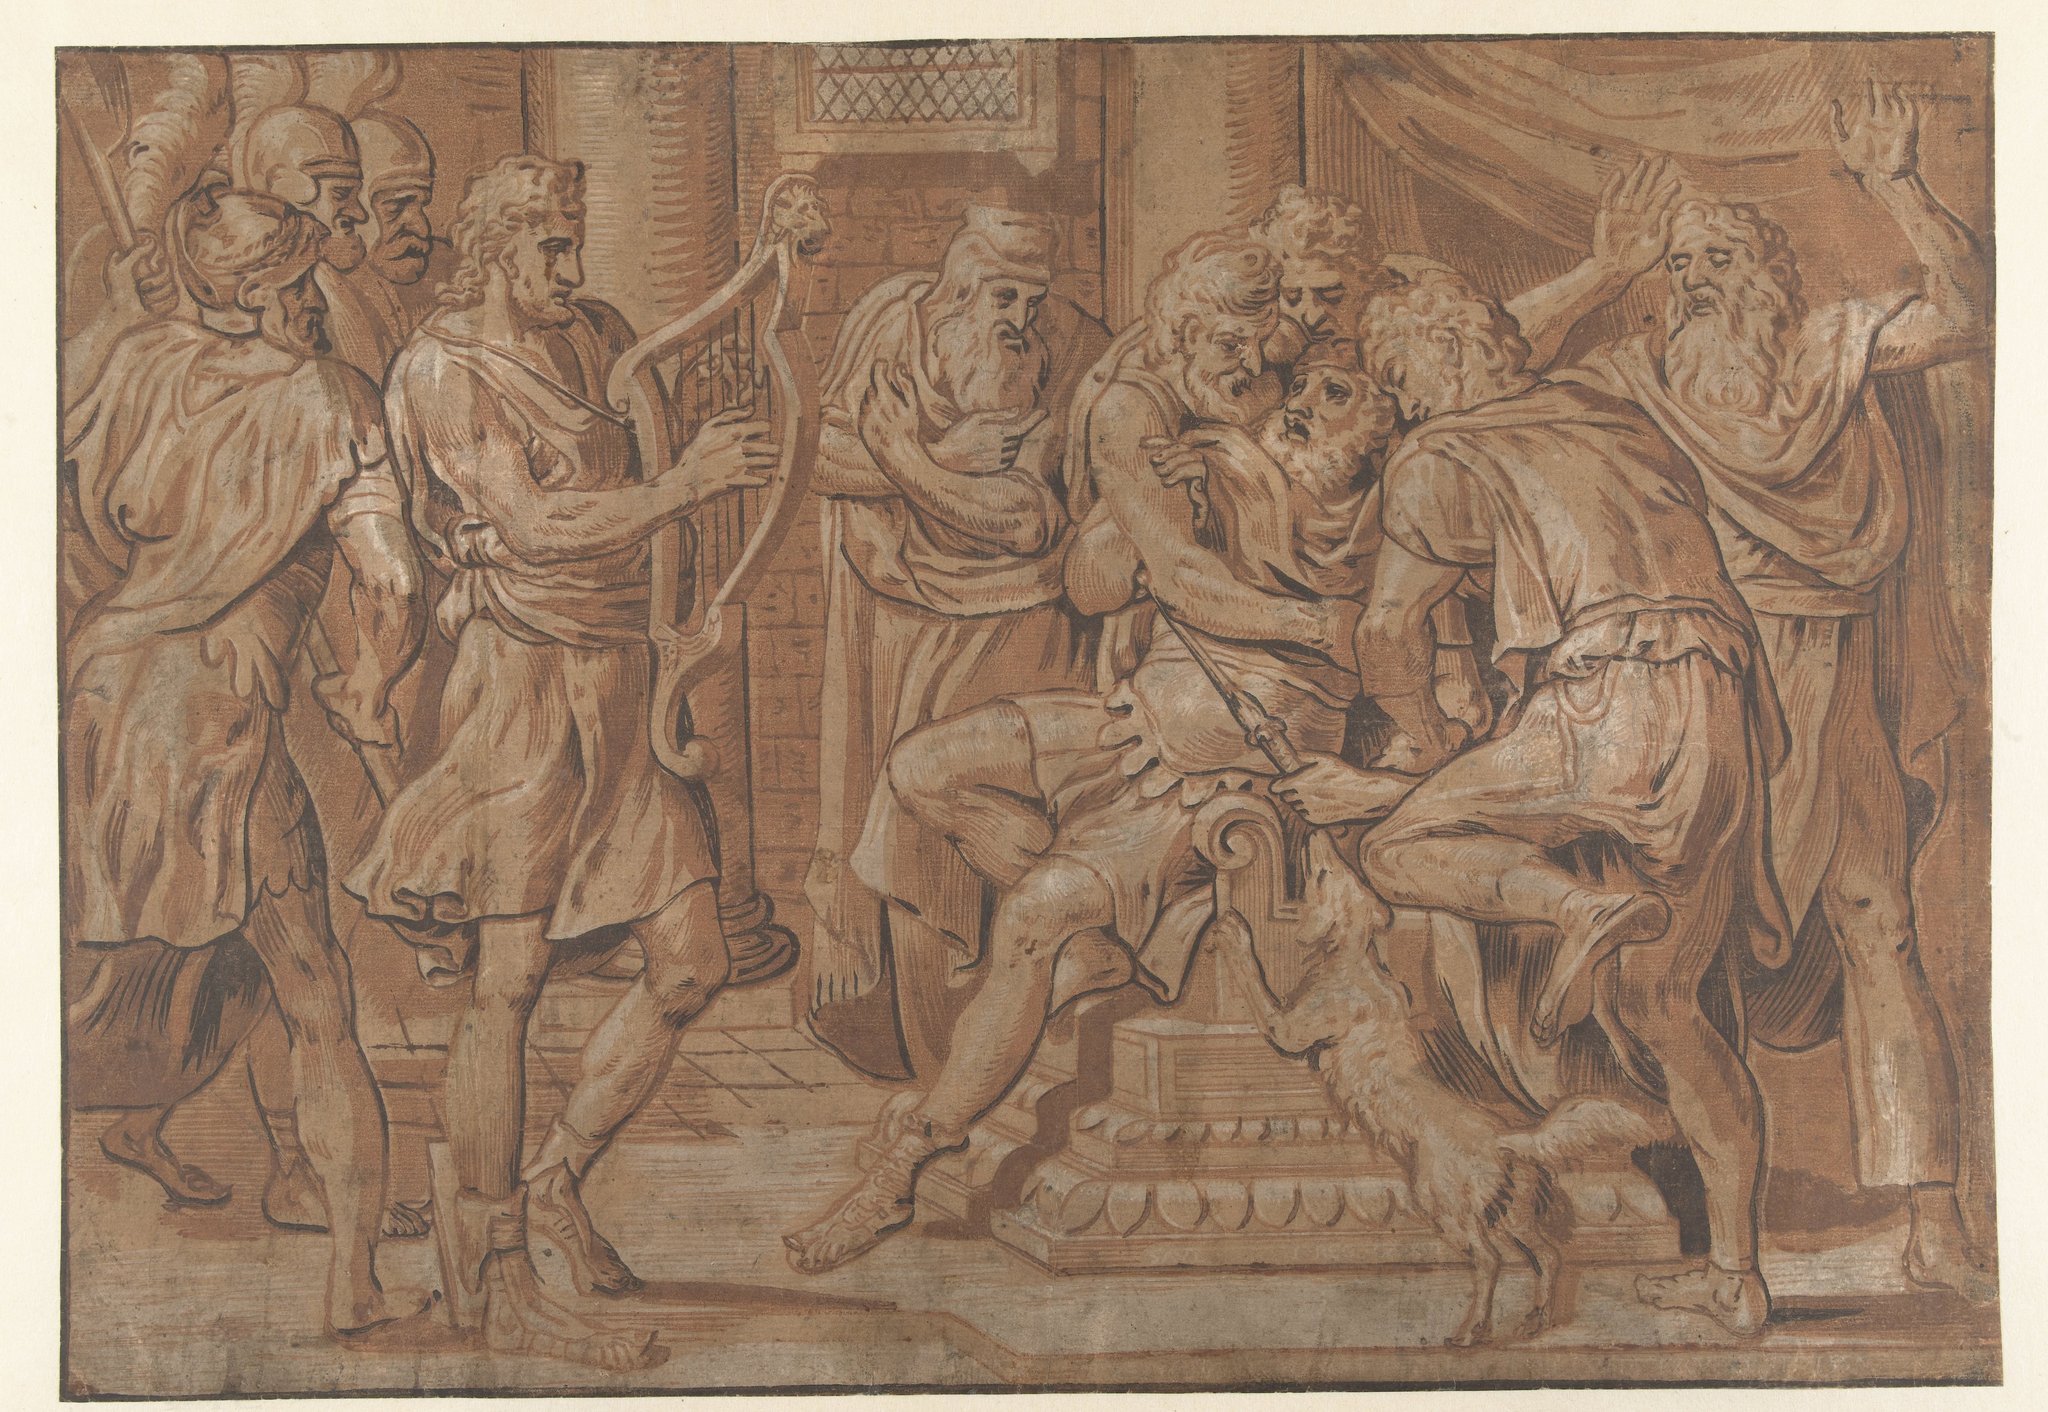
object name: print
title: David speelt harp voor Saul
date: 1555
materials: paper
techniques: brush, woodcut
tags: david playing his harp before saul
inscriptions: collector's mark: Lugt 2228, date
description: David speelt op zijn harp (lier) voor koning Saul. Chiaroscuro houtsnede gedrukt van vier blokken. Rechtsonder gesigneerd. Op voet van troon staat: SAUL. I. REG. CA. XVI.